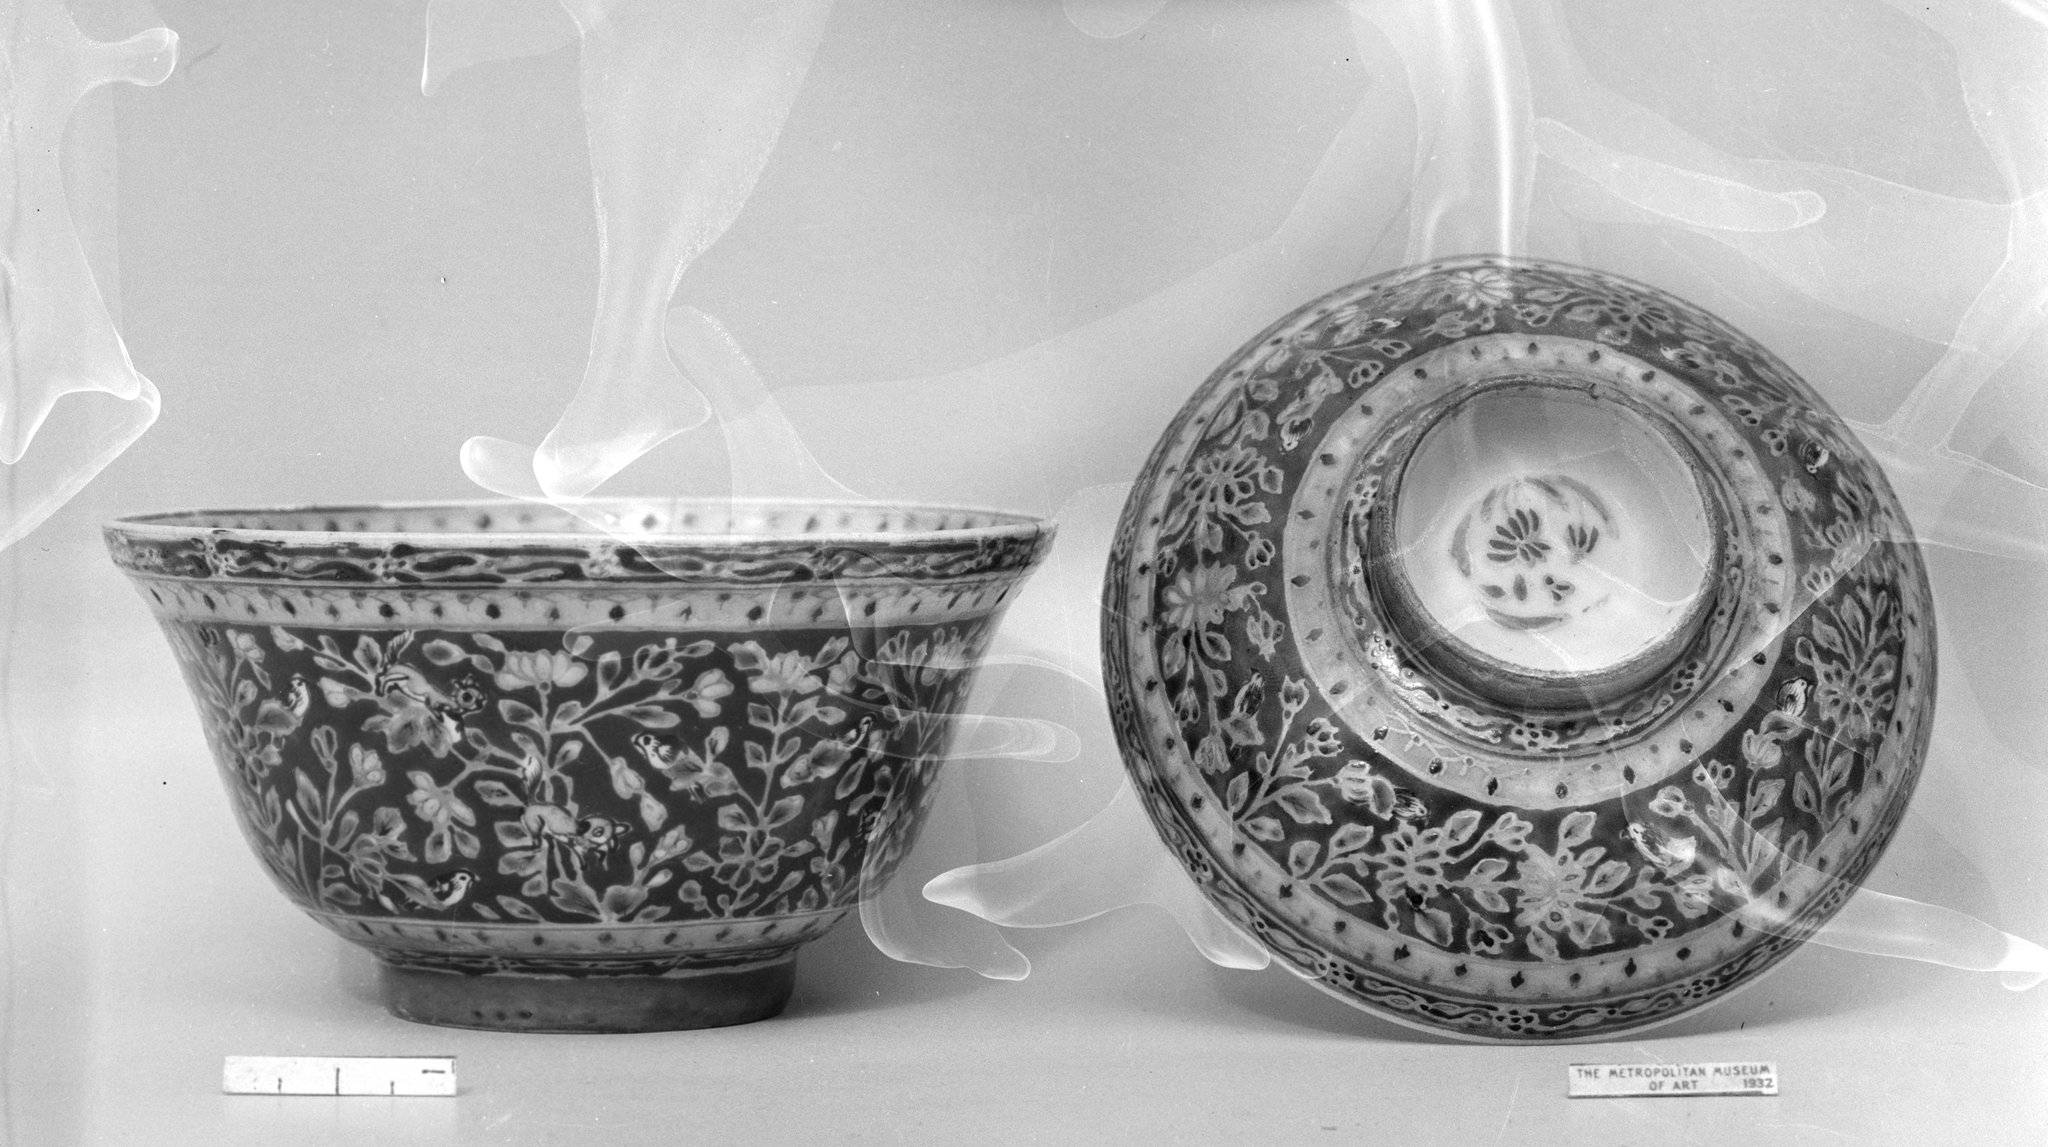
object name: covered bowl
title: Covered bowl with floral pattern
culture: chinese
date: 1801-1900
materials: enamel, porcelain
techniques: overglaze, painting, polychrome